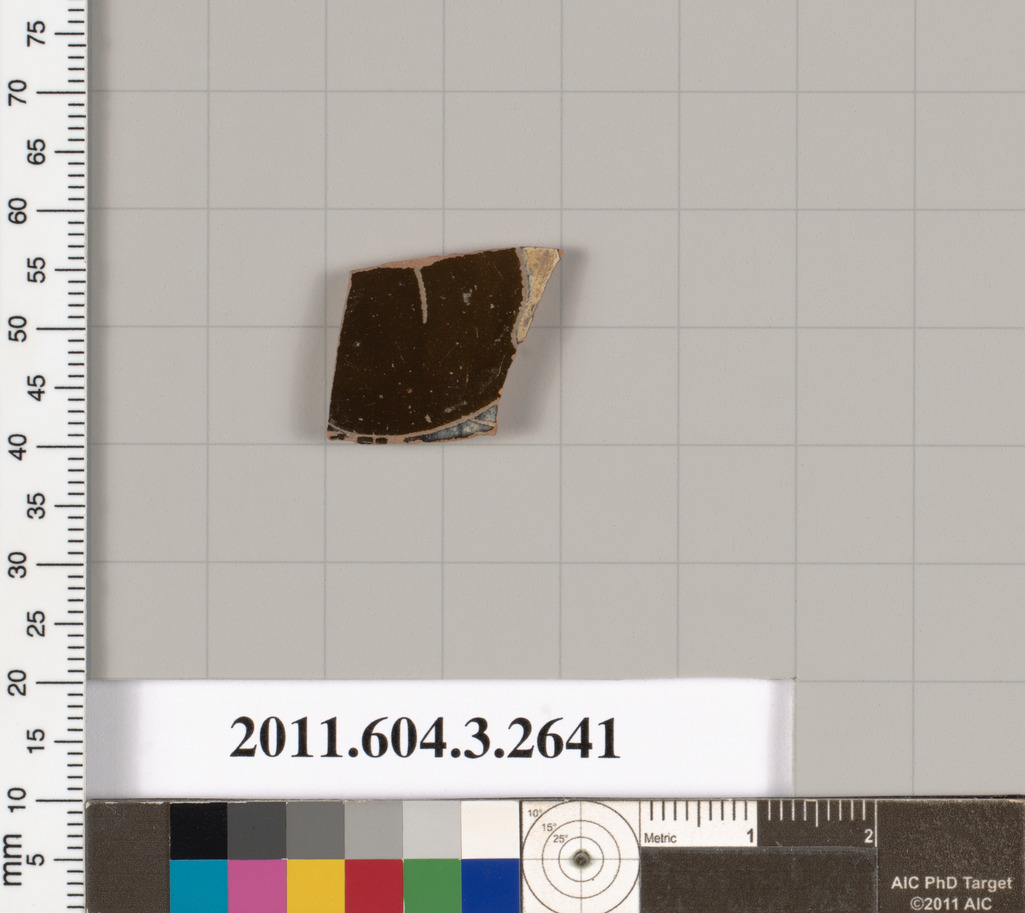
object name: undetermined closed shape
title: Terracotta fragment of a closed shape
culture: greek, attic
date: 600-401 BCE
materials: terracotta